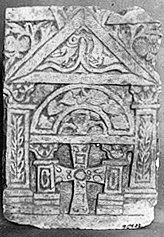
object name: stele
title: Funerary Stele with Cross at Center in Architectural Frame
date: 501-700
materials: limestone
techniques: carving, relief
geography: egypt